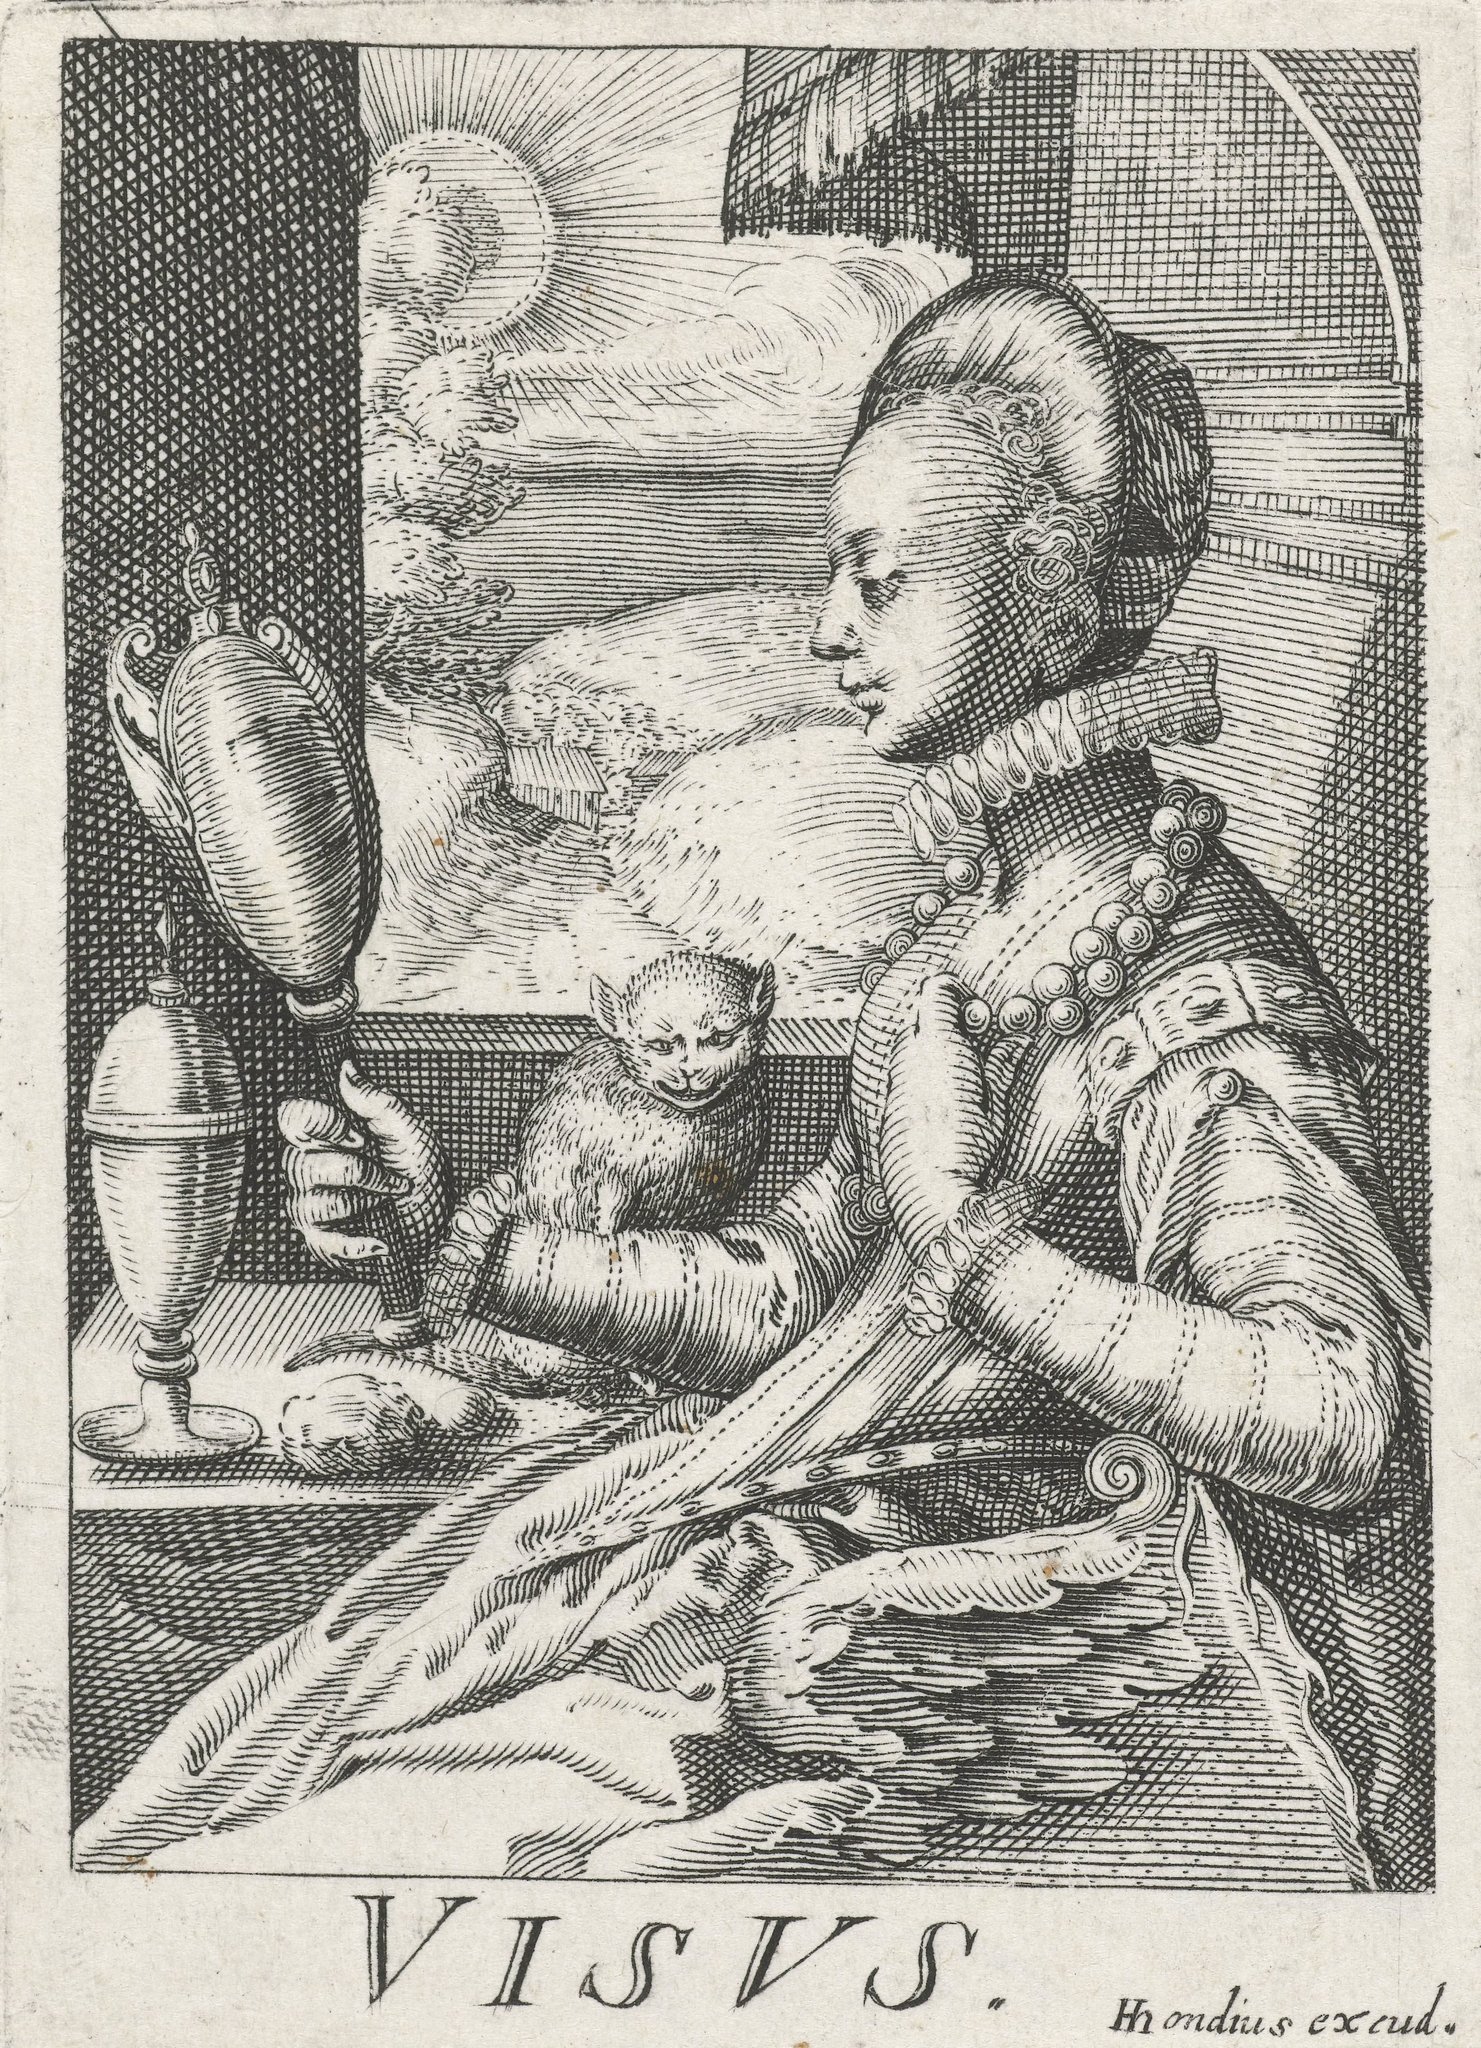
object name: print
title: Gezicht (Visus), een vrouw met een handspiegel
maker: andries jacobsz. stock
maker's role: print maker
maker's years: 1572-1648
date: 1583-1650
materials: paper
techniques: engraving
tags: sight, looking (one of the five senses)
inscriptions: collector's mark: Lugt 2228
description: Een elegante dame, zittend aan een tafel voor een open raam, houdt een handspiegel in haar hand en kijkt daarin naar zichzelf. Op de tafel zit een kat. Personificatie van het gezicht, prent uit een serie van de vijf zintuigen.